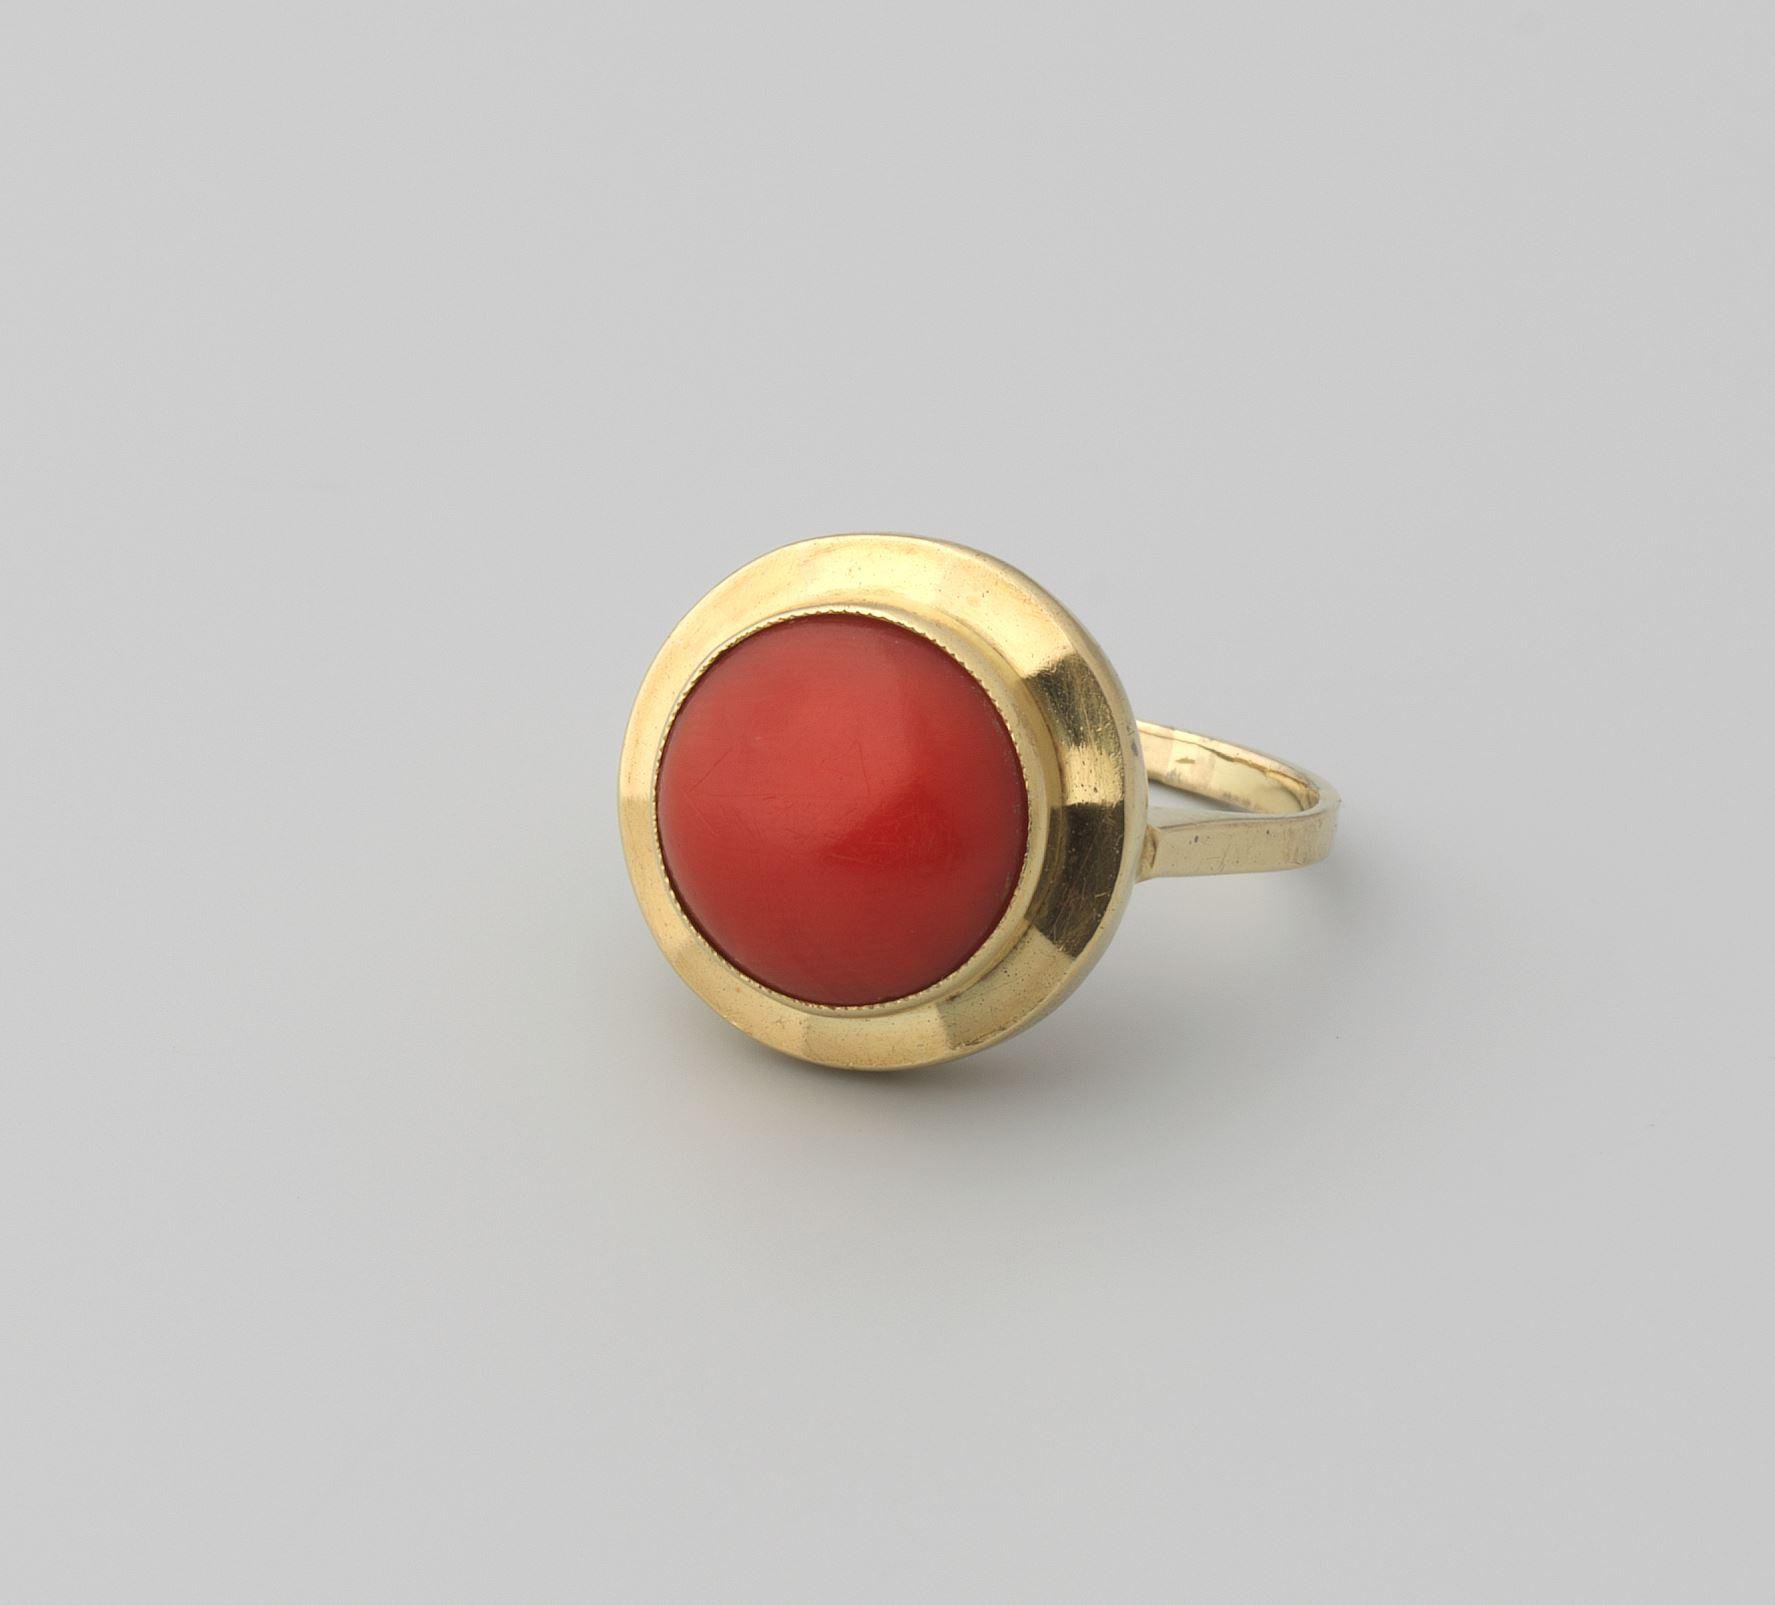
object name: ring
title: Ring van goud met bloedkoraal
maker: Anonymous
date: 1960-1970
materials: gold, coral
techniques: grinding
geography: netherlands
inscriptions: alloy mark: ‘eikenblad 585’, maker's mark: ‘JV’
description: Ring van goud met rond cabochon geslepen bloedkoraal.